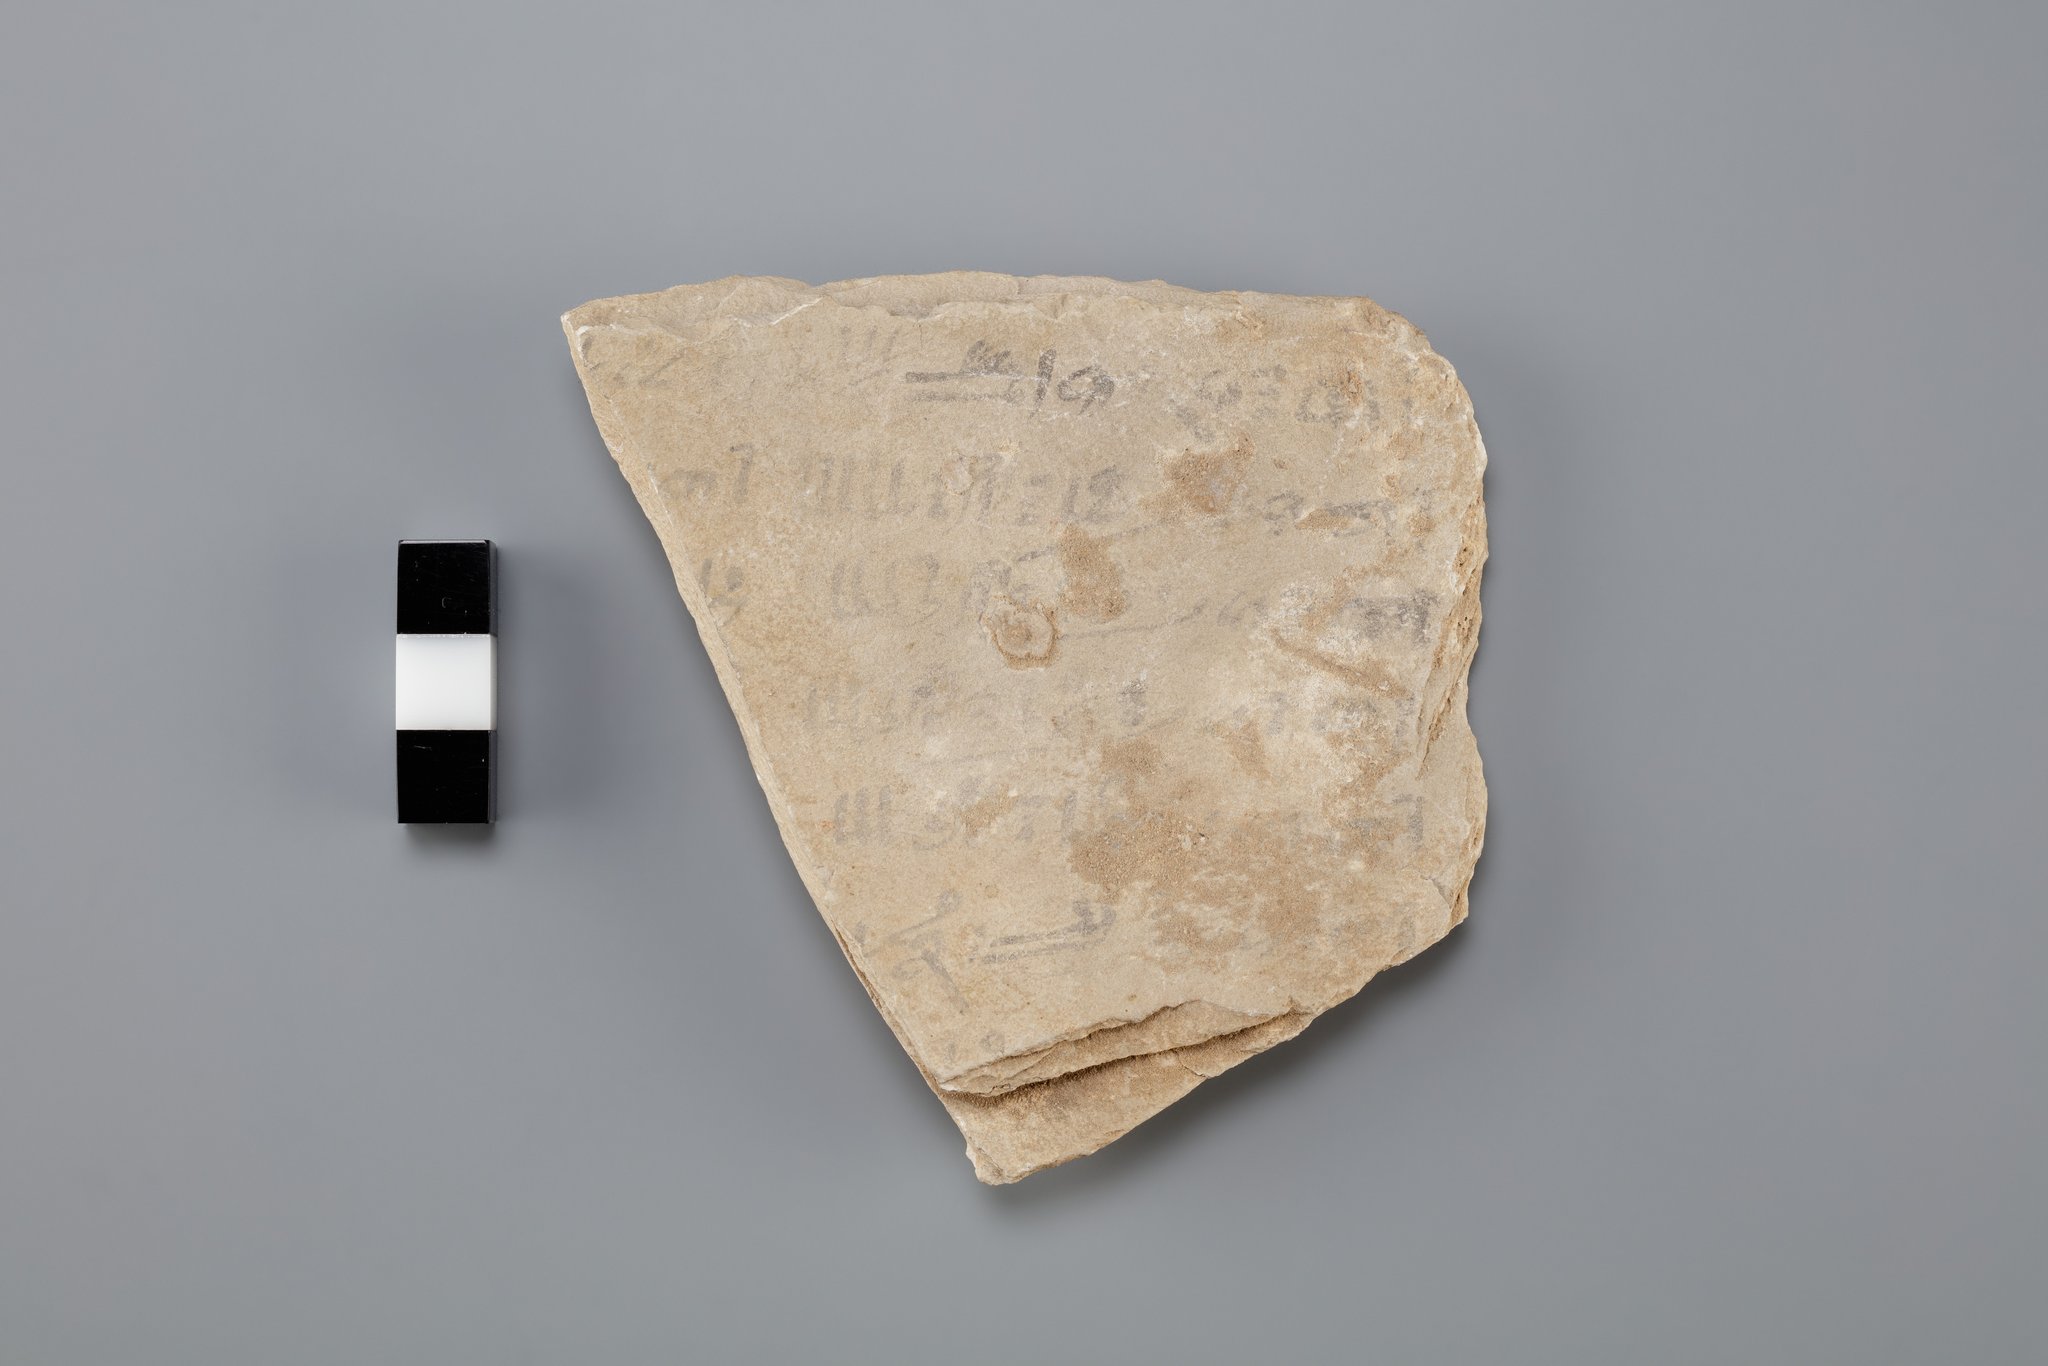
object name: ostracon, hieratic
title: Hieratic ostracon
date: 1295-1070 BCE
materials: ink, limestone, paint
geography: egypt